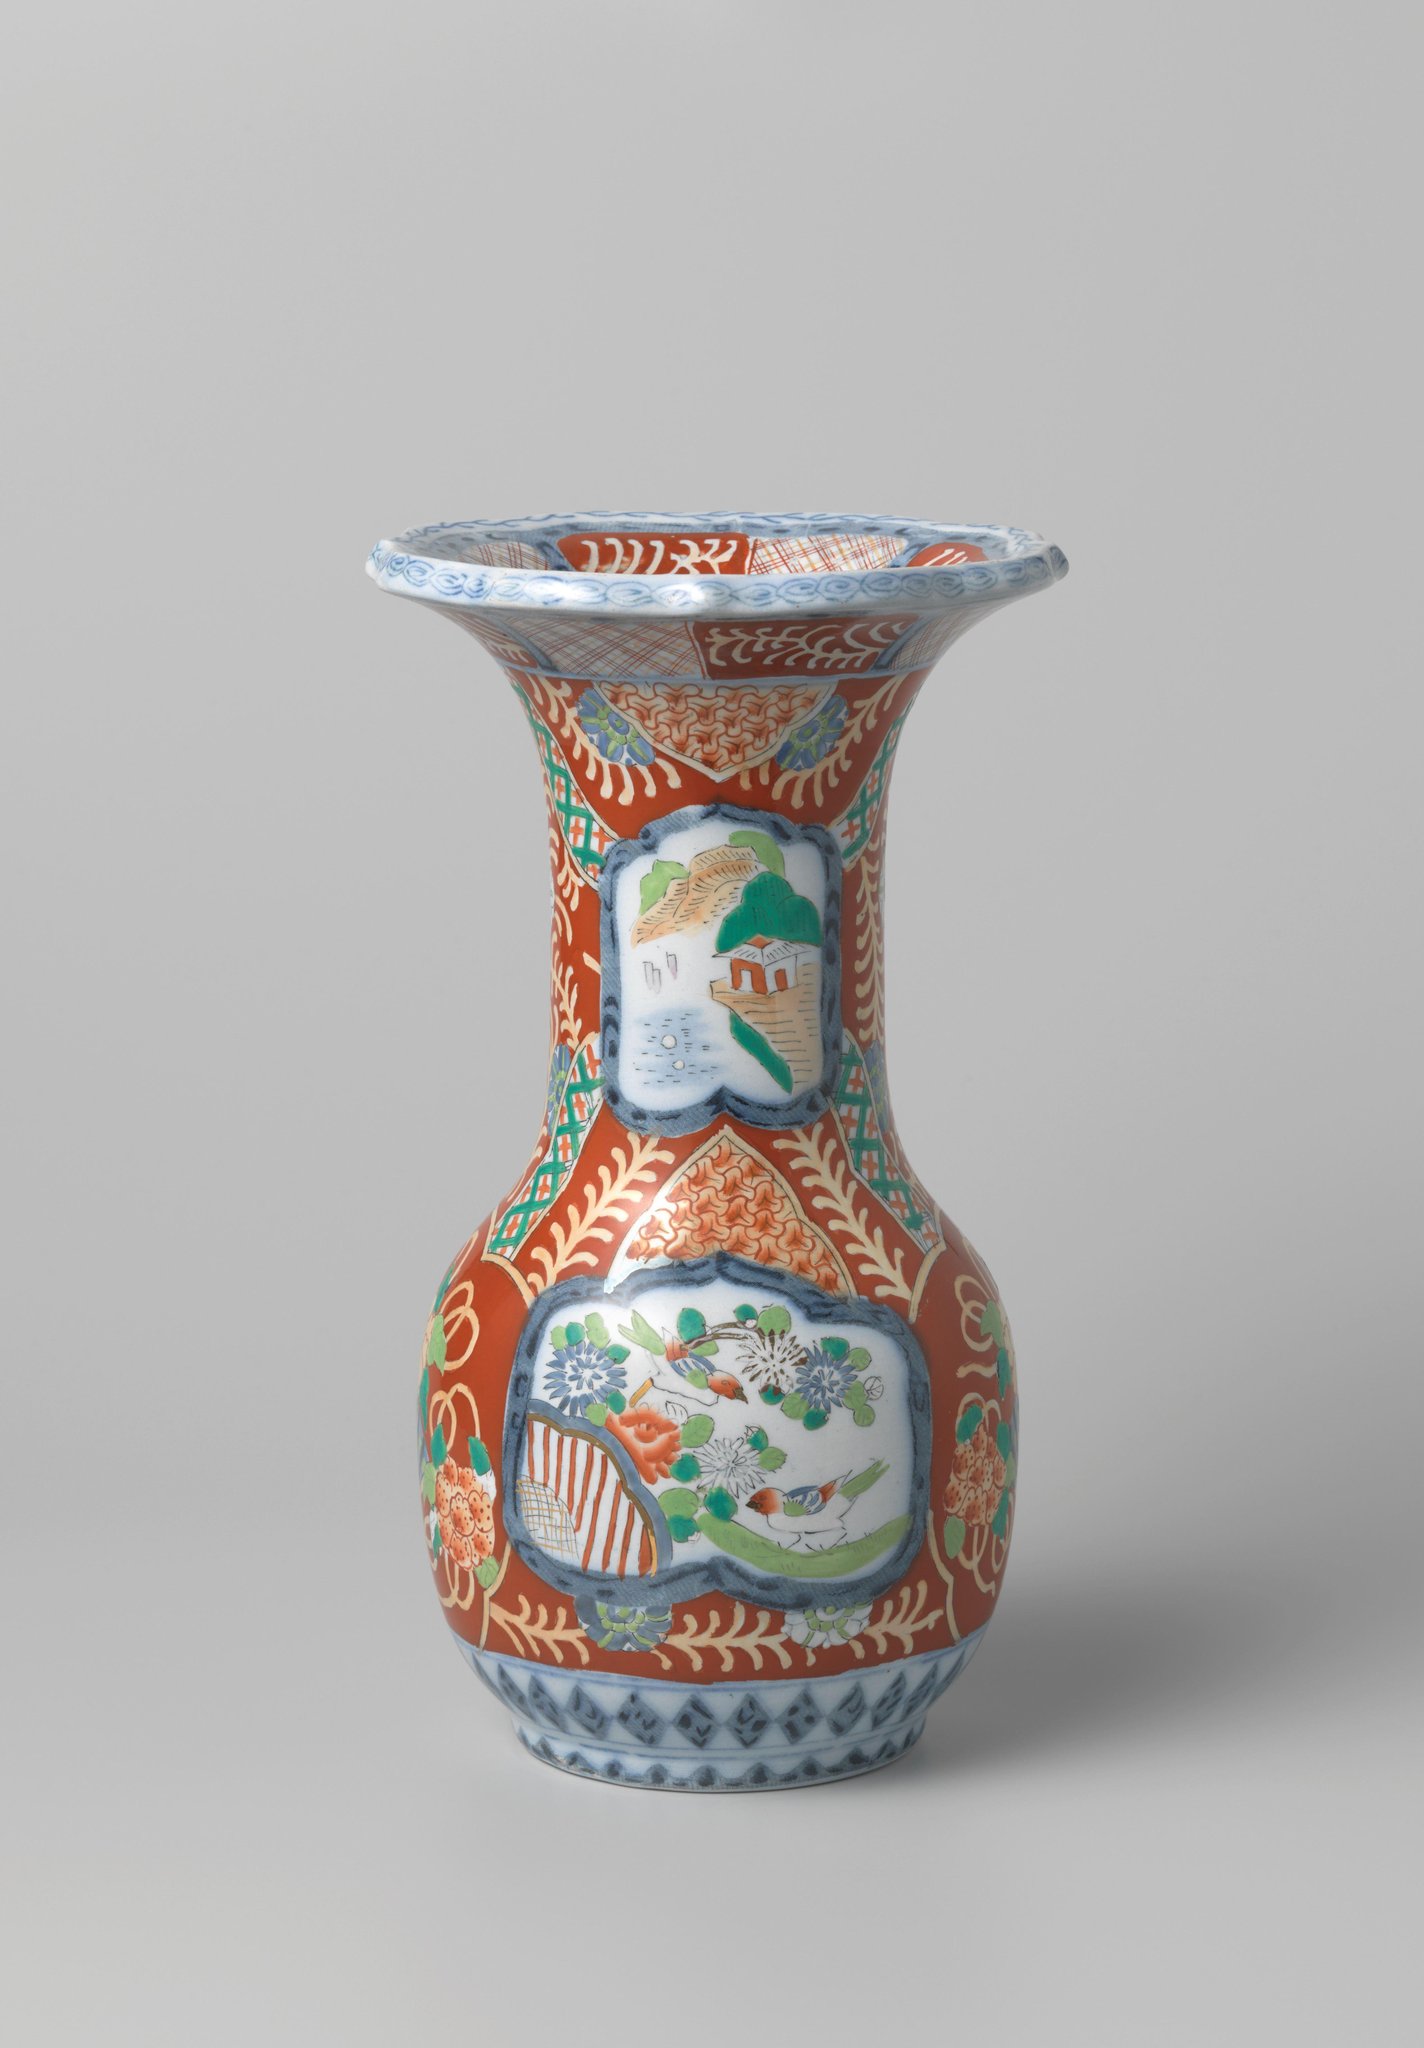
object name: vase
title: Vaas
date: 1886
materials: earthenware, glaze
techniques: vitrification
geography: maastricht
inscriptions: mark: ‘Sfinx // P. REGOUT & Co // MAASTRICHT’, check stamp: ‘D 3’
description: Vaas van aardewerk, behorend bij een driedelig kaststel, met zwarte en vloeiblauwe transferdecoratie, beschilderd met emailkleuren en okerluster, met goud gehoogd. Op de buik twee cartouches met vogels en takken, op de hals twee cartouches met een landschap.